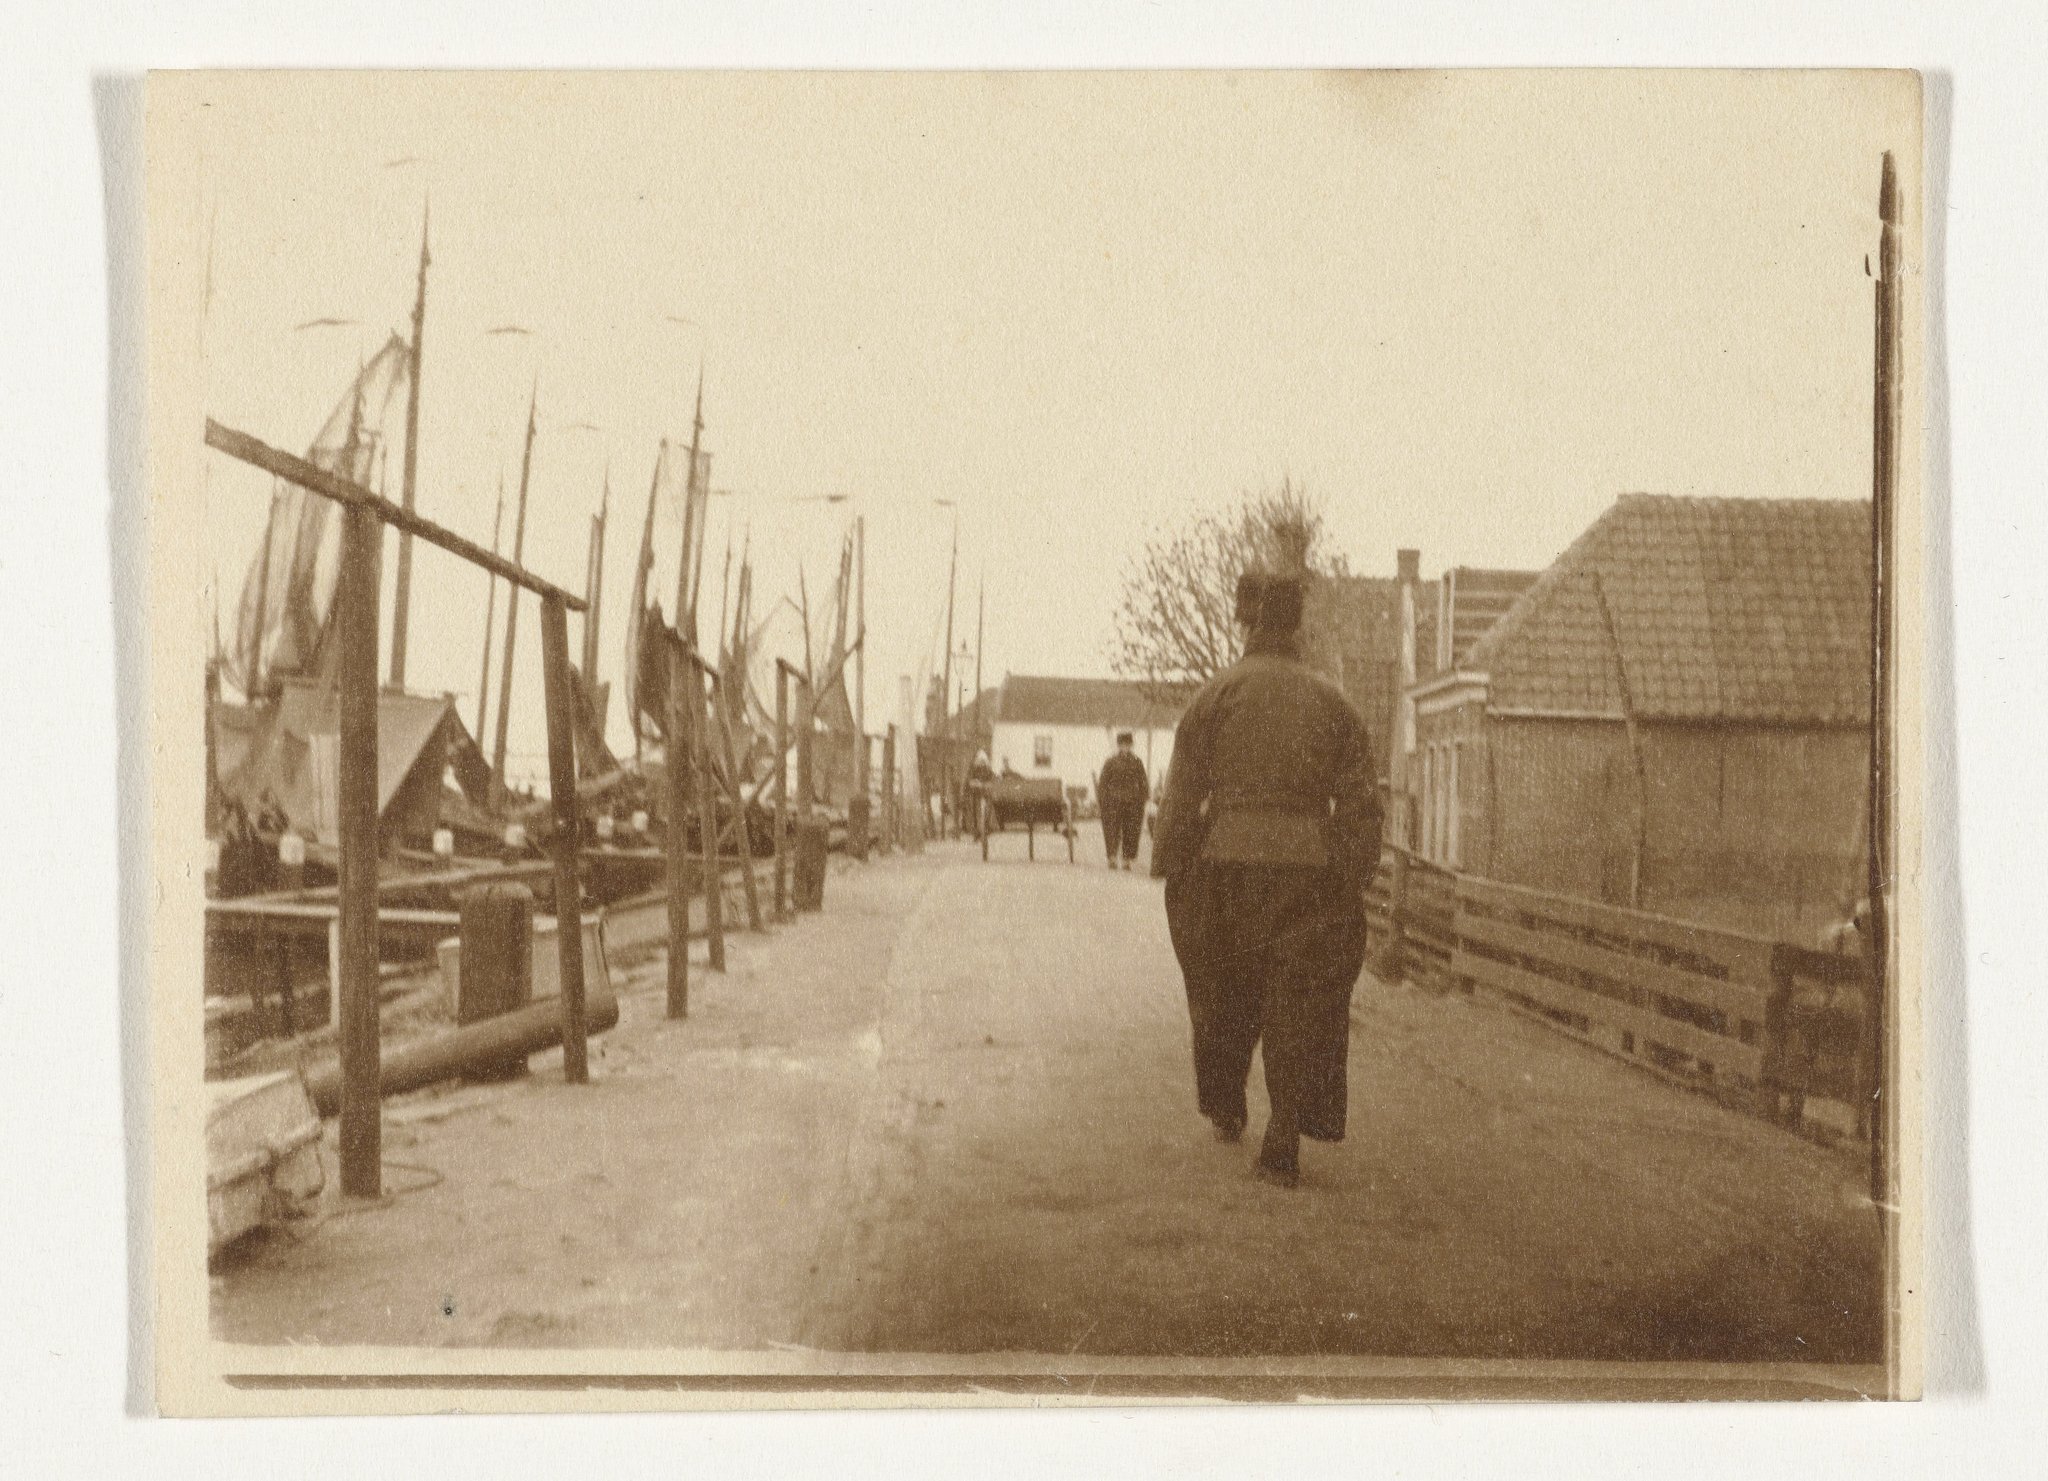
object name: photograph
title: Mannen in klederdracht langs de haven in Volendam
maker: george hidderley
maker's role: fotograaf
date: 1900-1910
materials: photographic support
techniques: salted paper print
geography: volendam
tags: adult man, folk costume, regional costume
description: Was oorspronkelijk los ingevoegd in album RP-F-2002-105